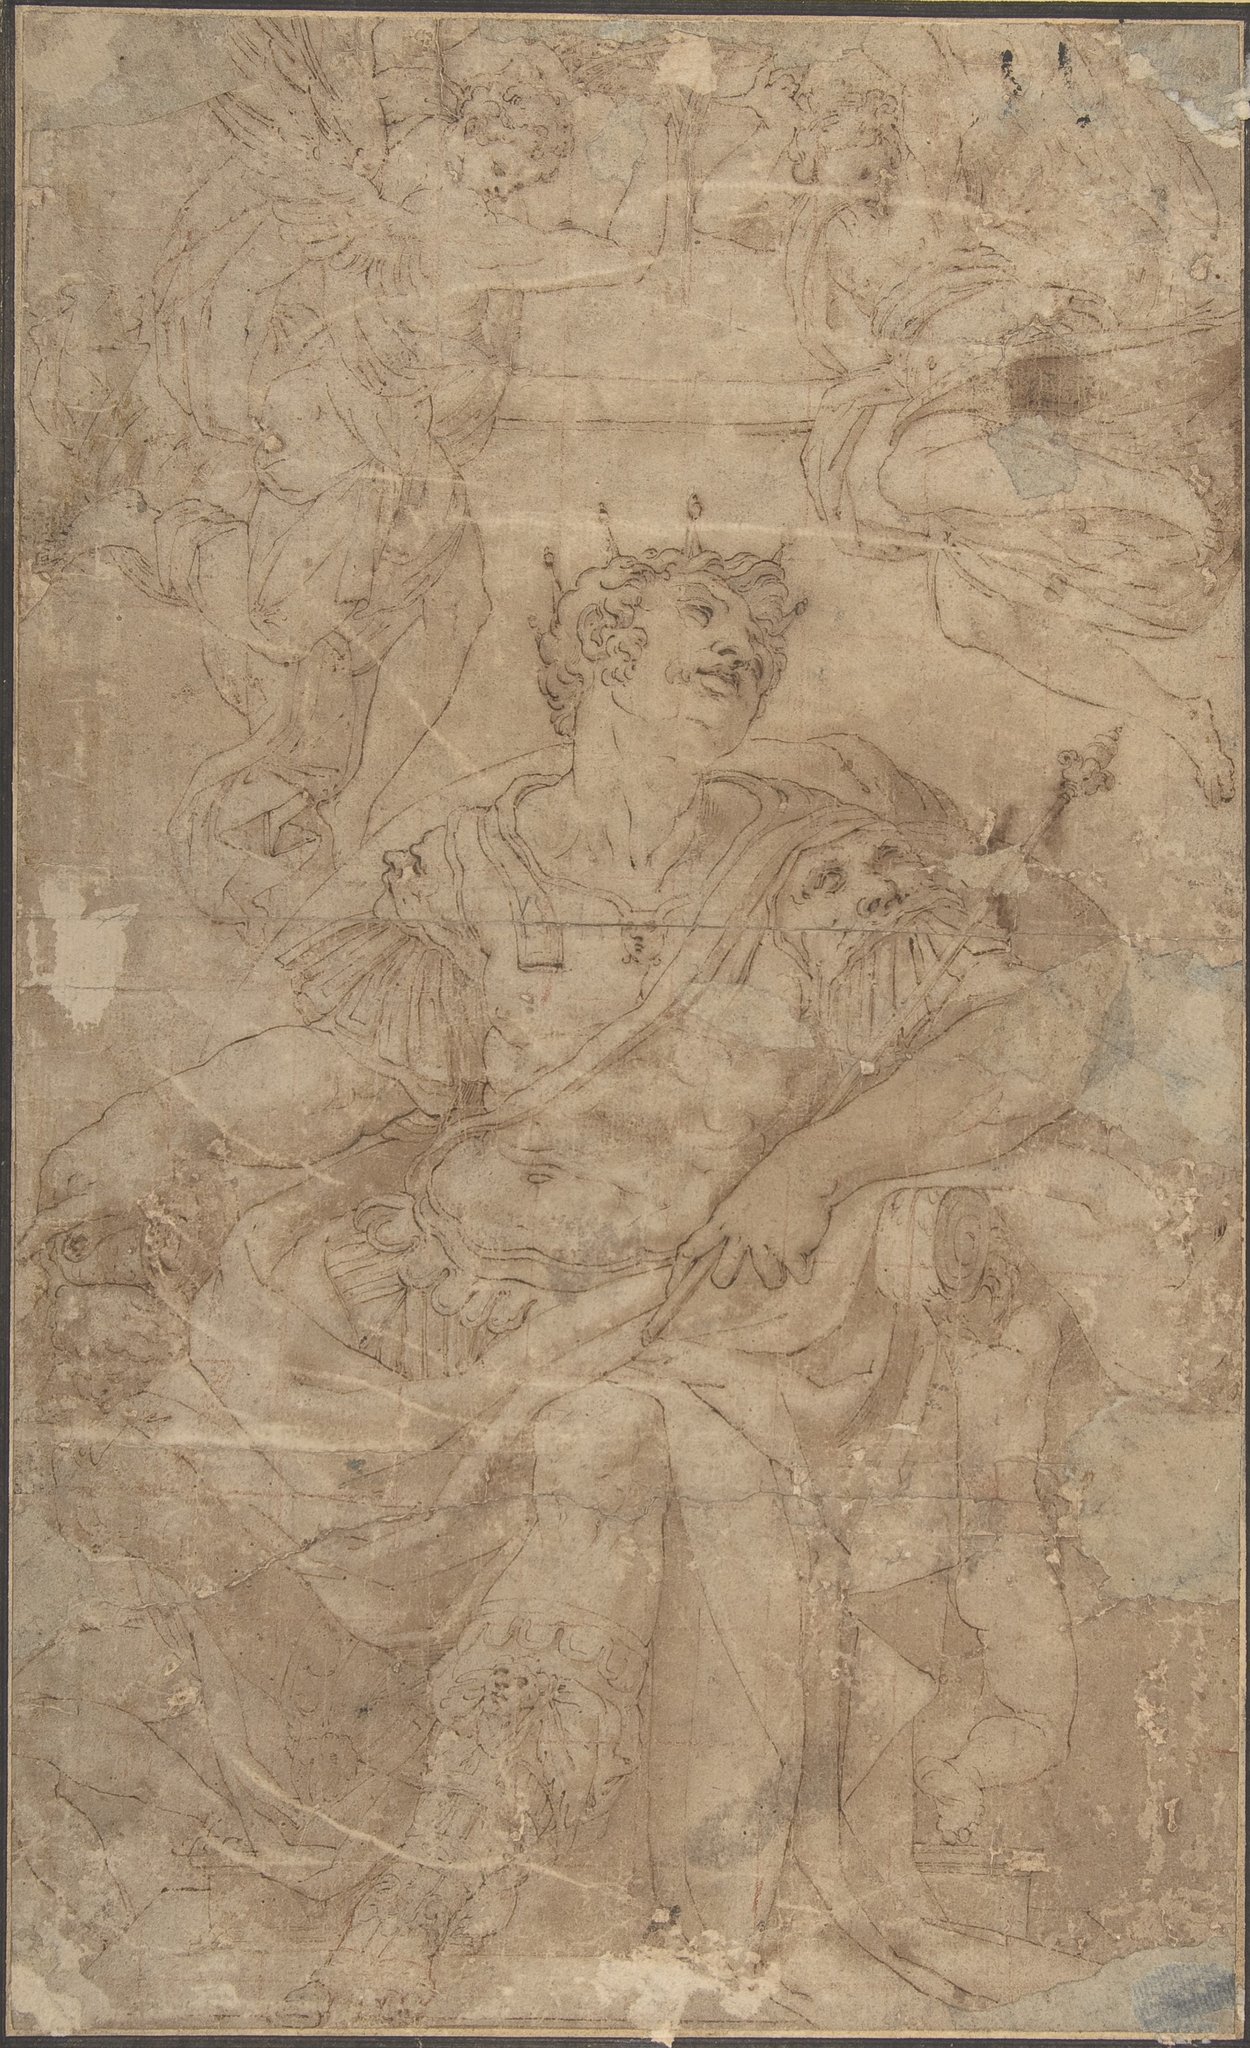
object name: drawing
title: A Seated King in Armor (King David?)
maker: orazio samacchini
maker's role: artist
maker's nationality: italian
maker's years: 1532-1577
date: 1501-1600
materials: chalk, ink, paper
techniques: brush, pen, drawing, wash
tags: armor,kings